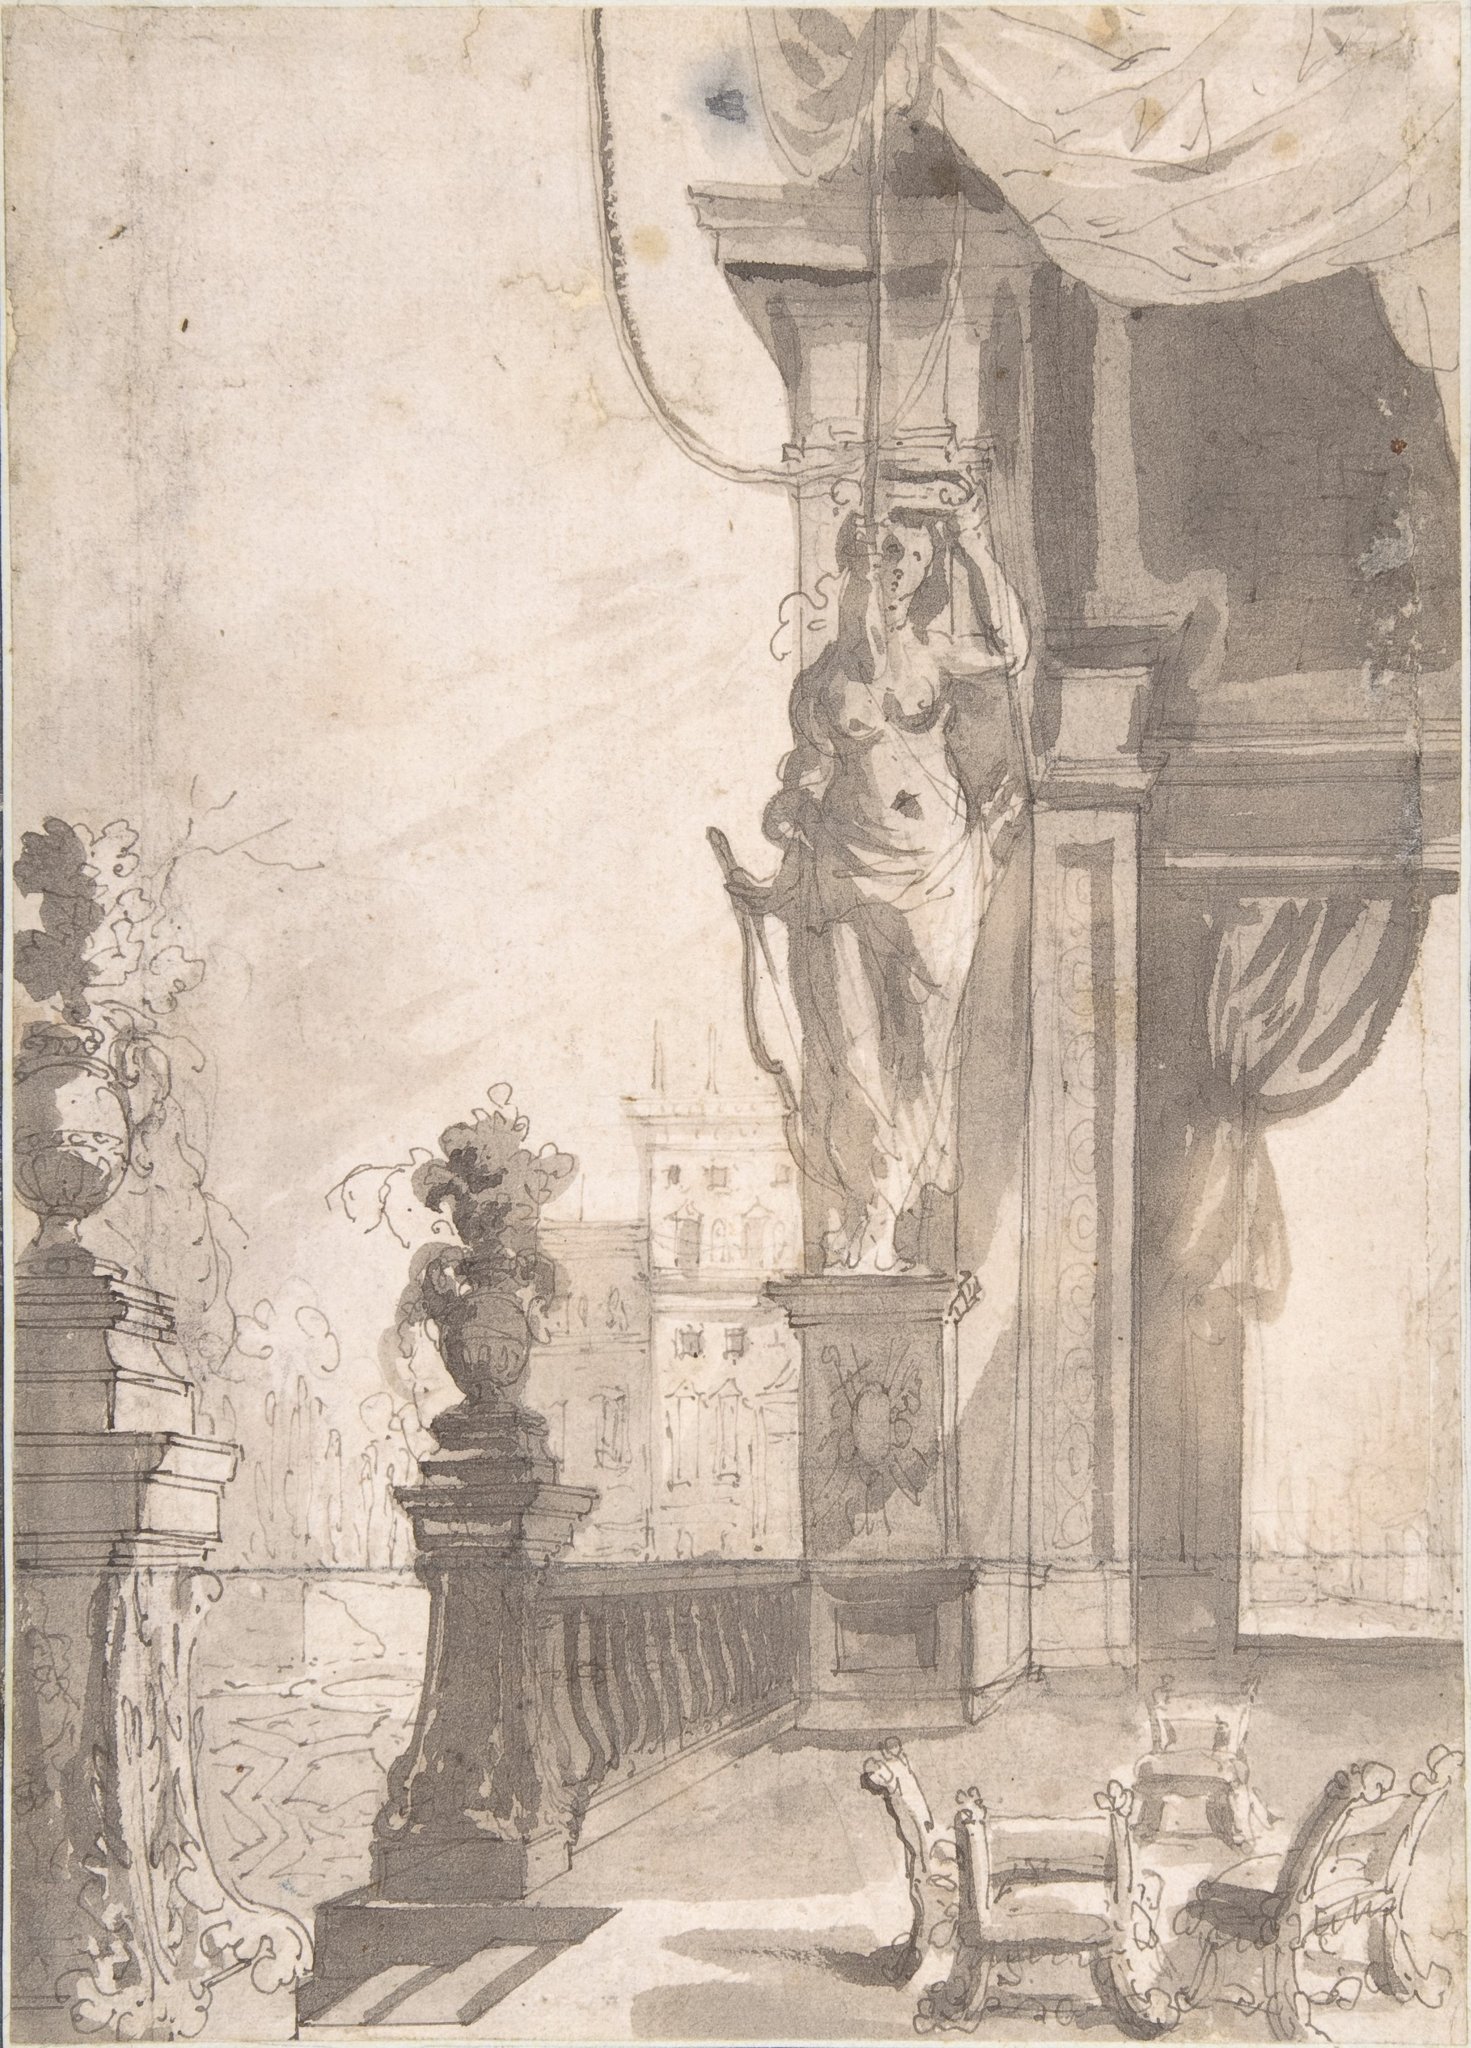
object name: drawing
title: Roman Capriccio with Terrace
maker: anonymous, italian, 17th or 18th century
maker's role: artist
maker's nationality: italian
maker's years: 1600-1799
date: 1601-1800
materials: chalk, graphite, ink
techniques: brush, pen, drawing, wash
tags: buildings,caryatids,women